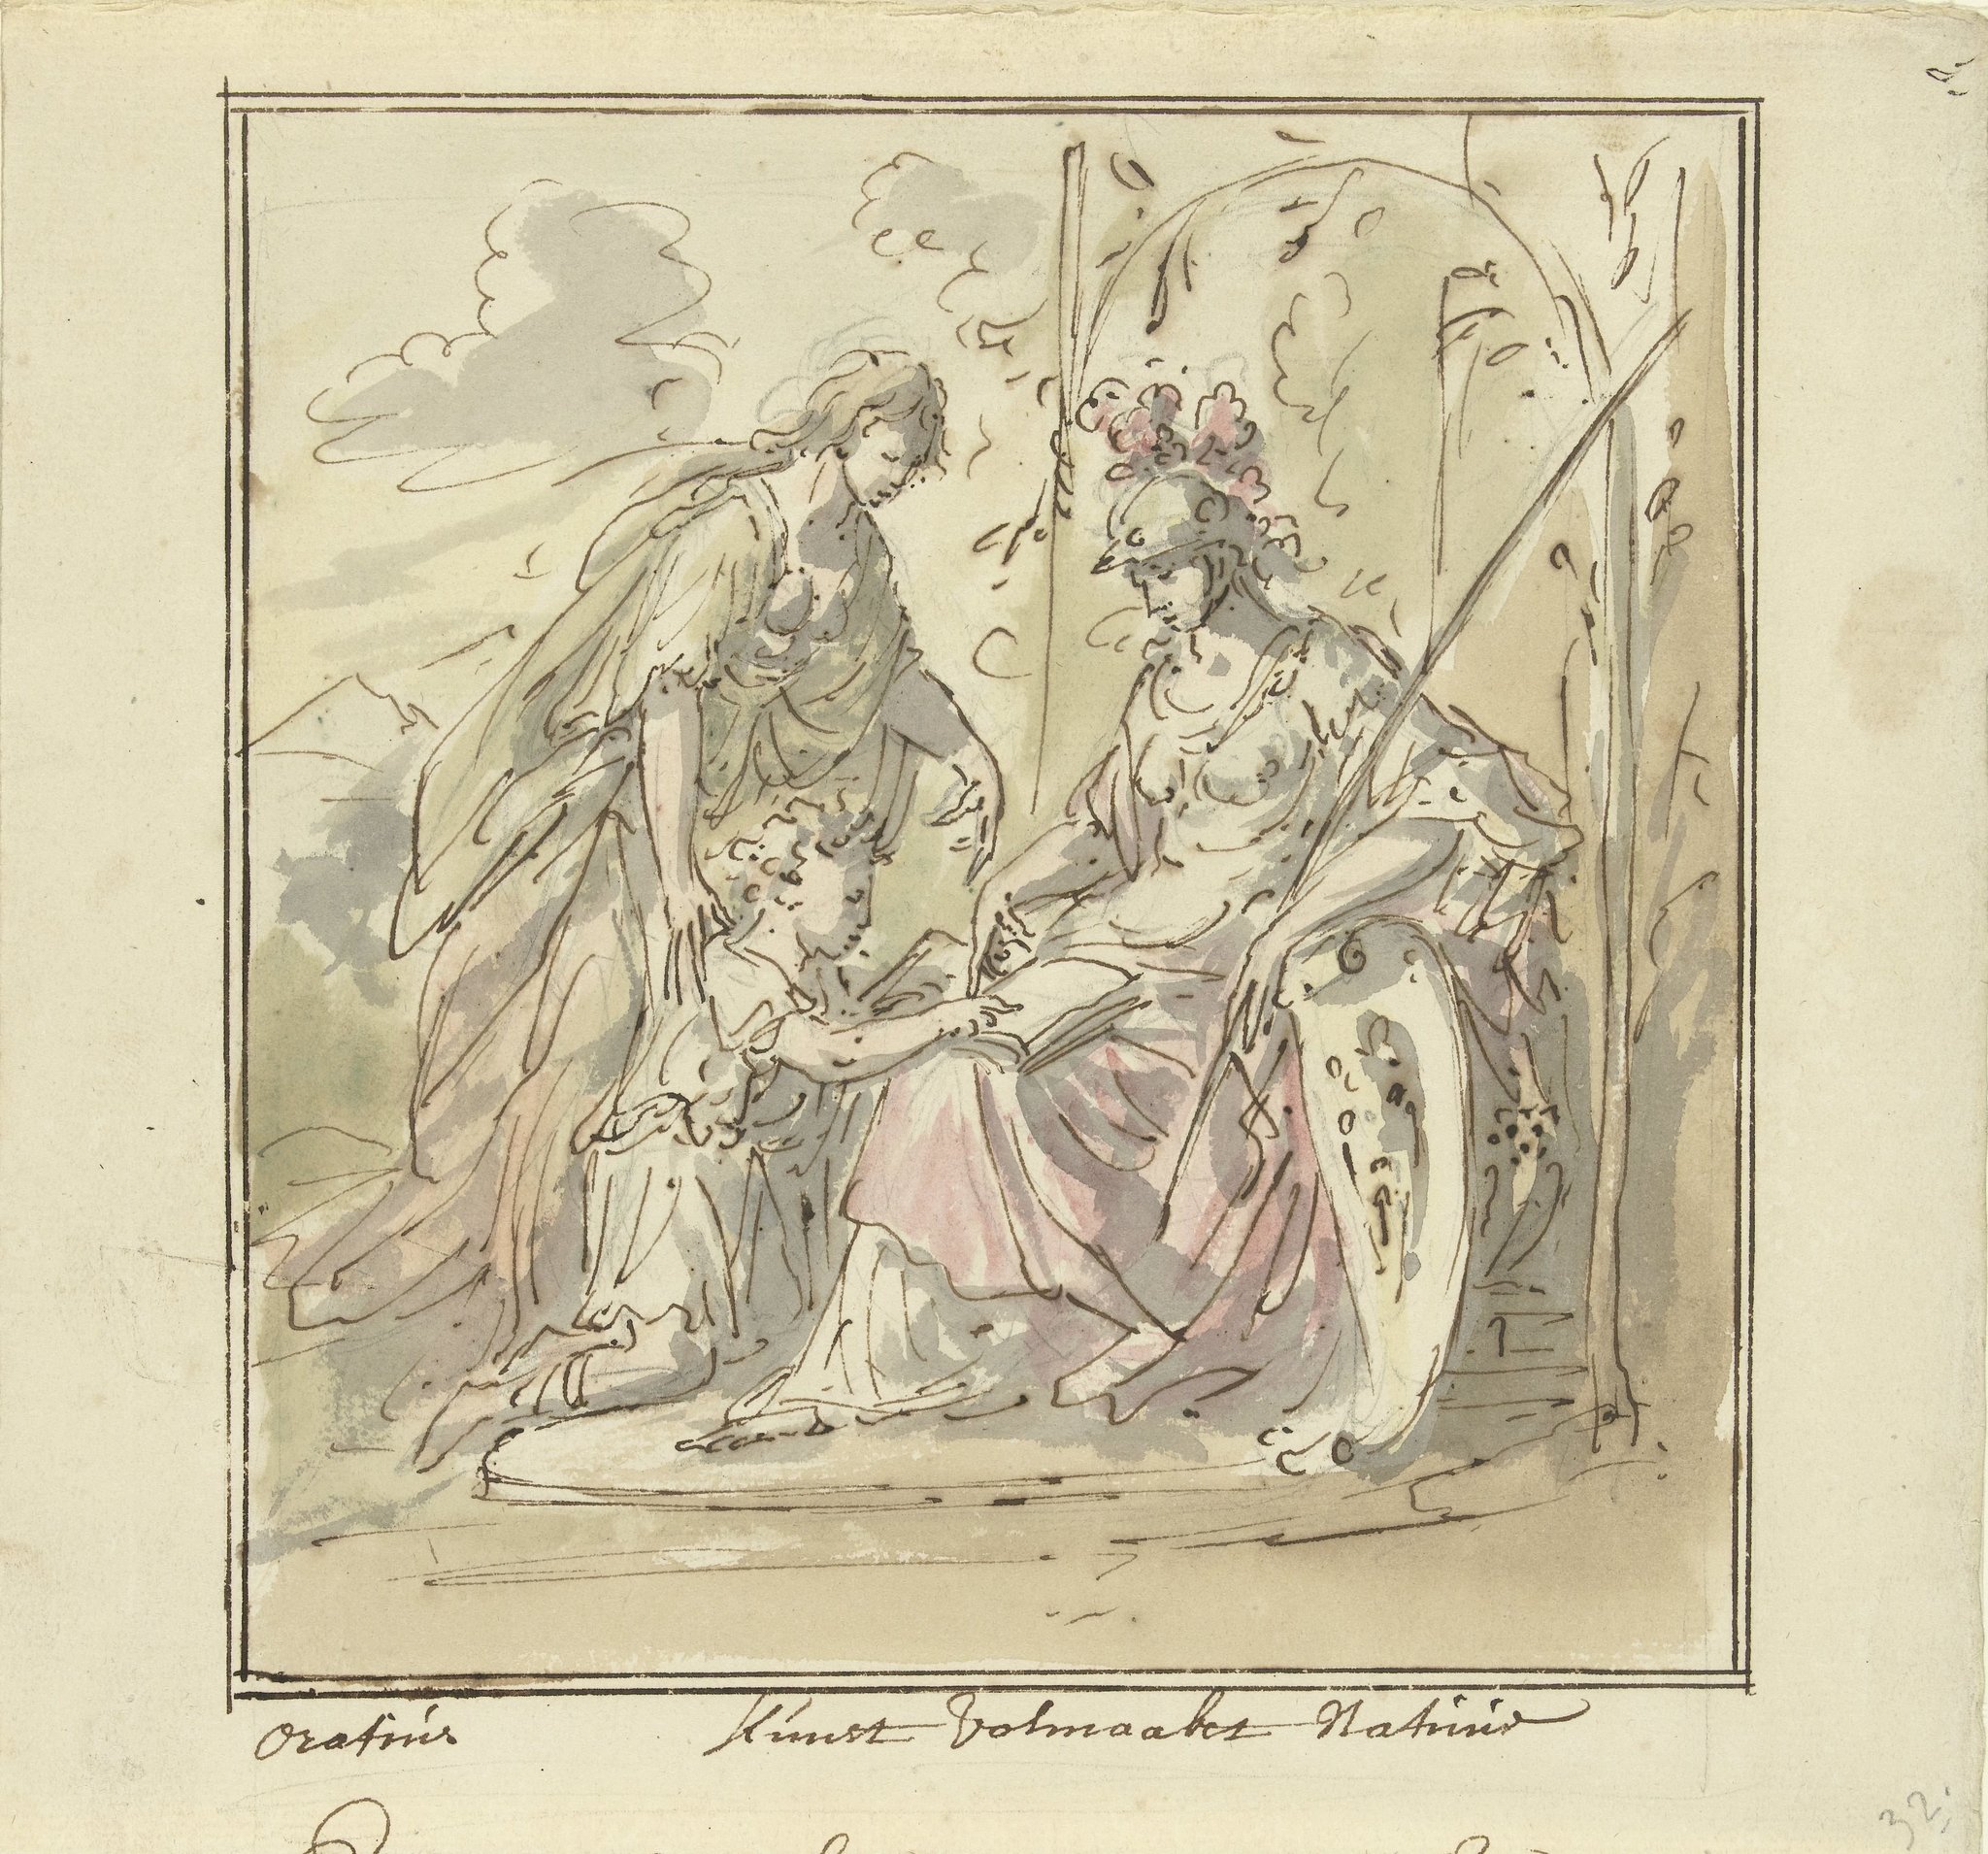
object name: drawing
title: De Kunst vervolmaakt de Natuur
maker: elias van nijmegen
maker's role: draughtsman, painter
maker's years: 1667-1755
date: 1677-1755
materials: ink, paper, pencil, watercolor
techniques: brush, pen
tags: 'natura' (allegorical figure or scene; or as diana of ephesus, with many breasts); 'natura' (ripa), minerva as patroness, art, symbolic representations, allegories and emblems ~ education; 'ammaestramento', dottrina', 'educatione', 'istitutione' (ripa)